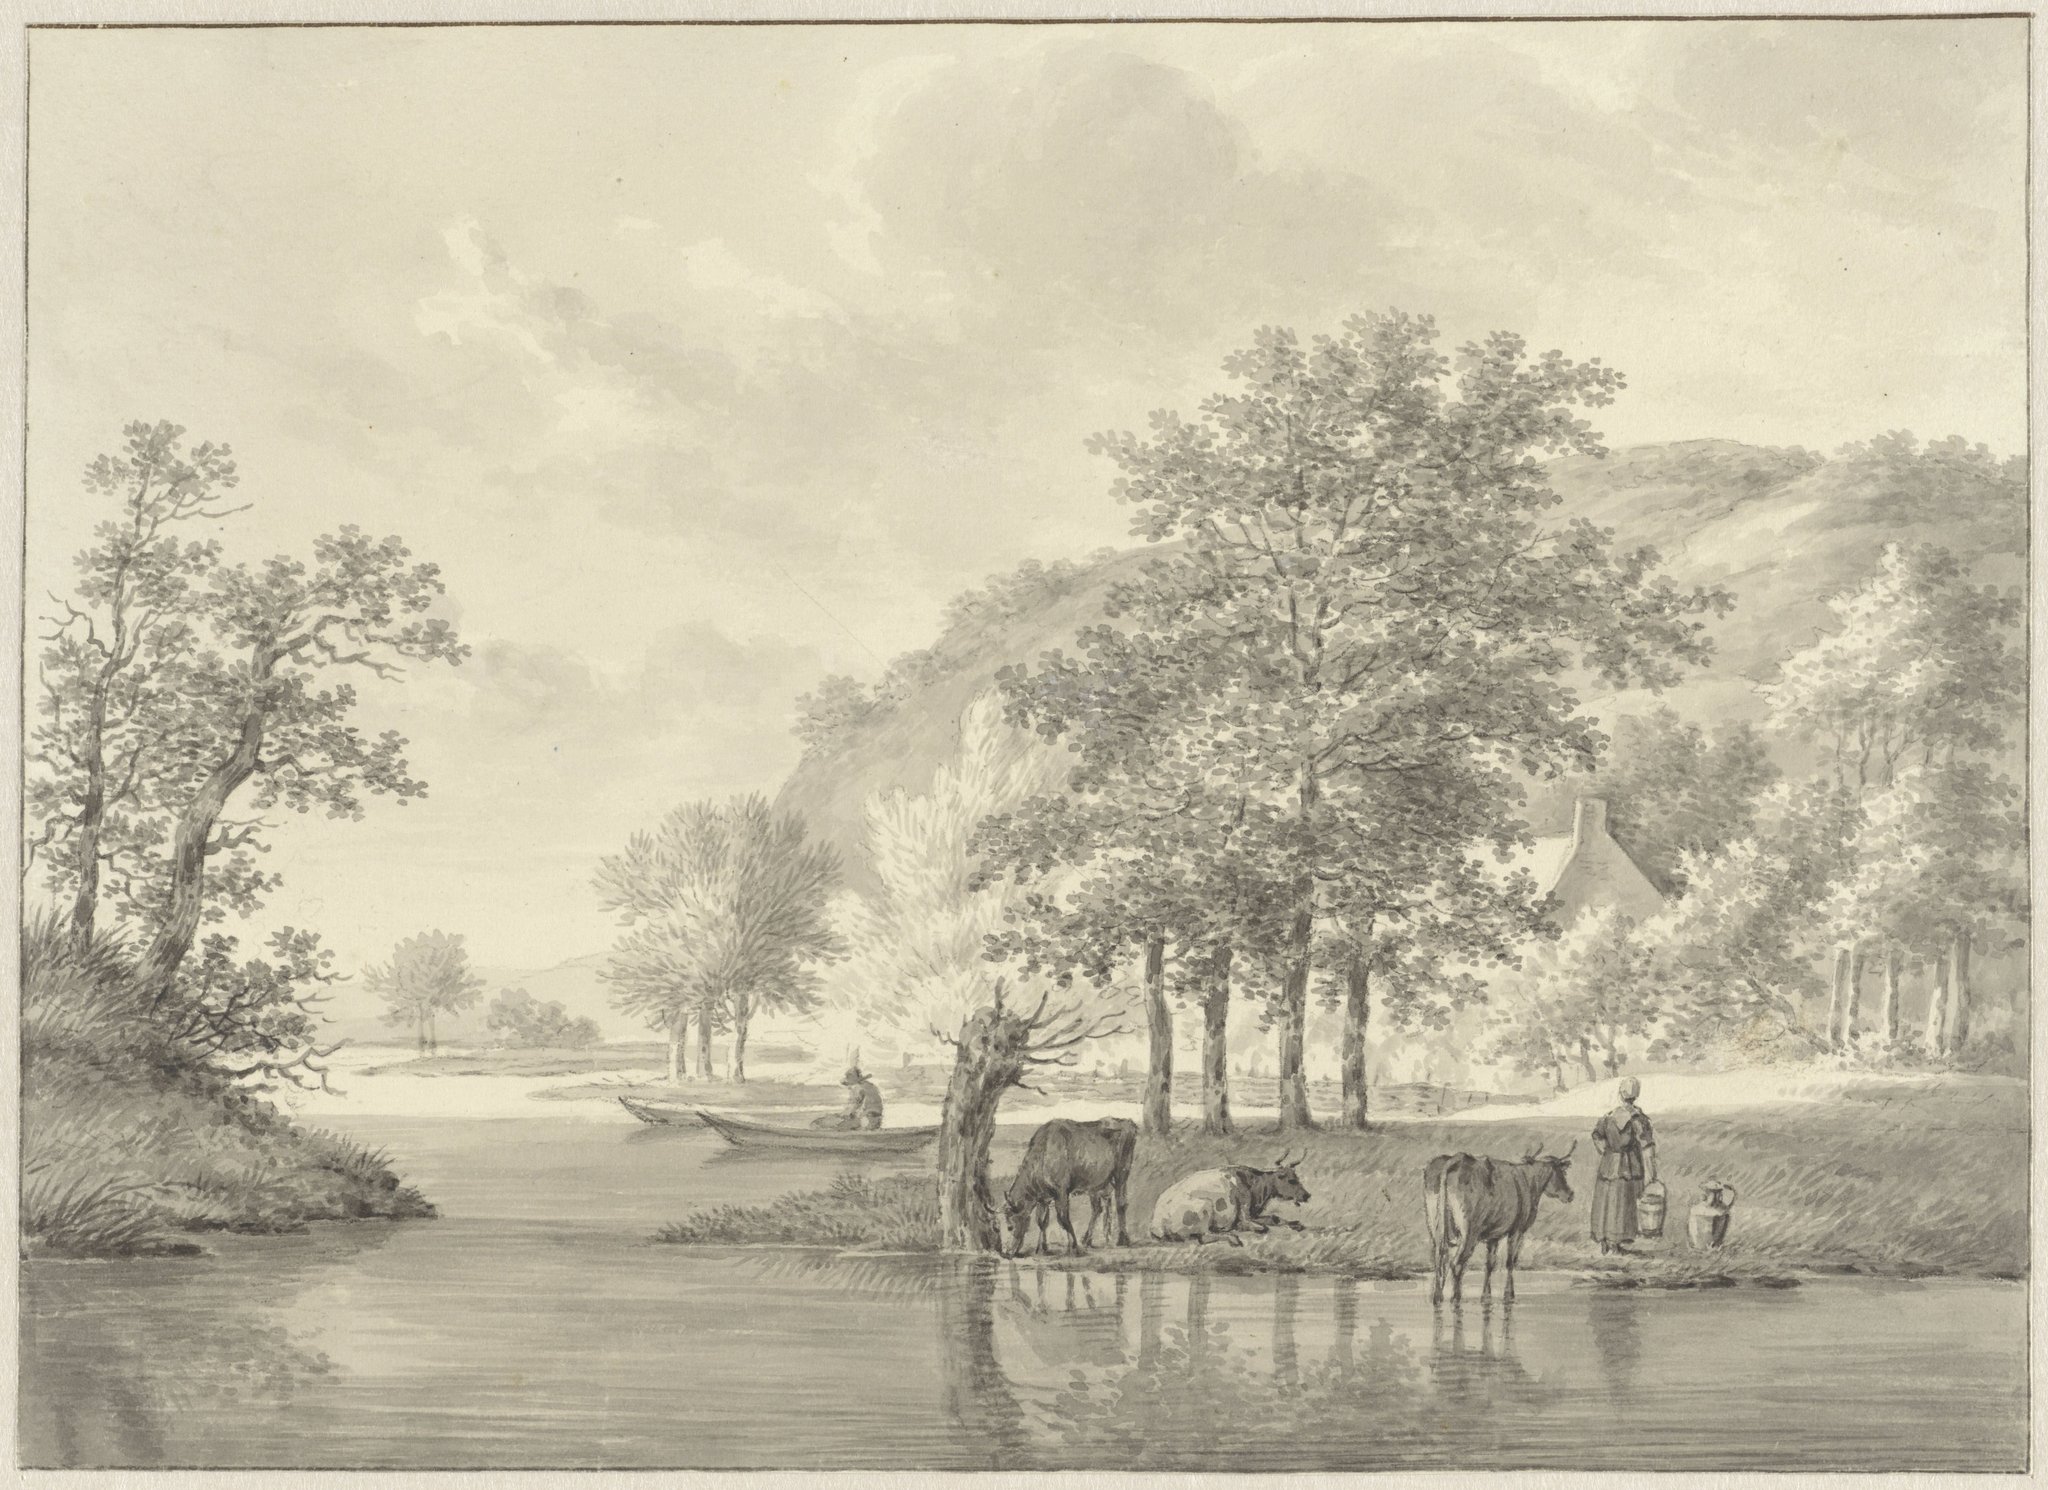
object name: drawing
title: Rivierlandschap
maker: anthony oberman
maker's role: draughtsman, painter, print maker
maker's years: 1781-1845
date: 1791-1845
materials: chalk, paper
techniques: brush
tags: river